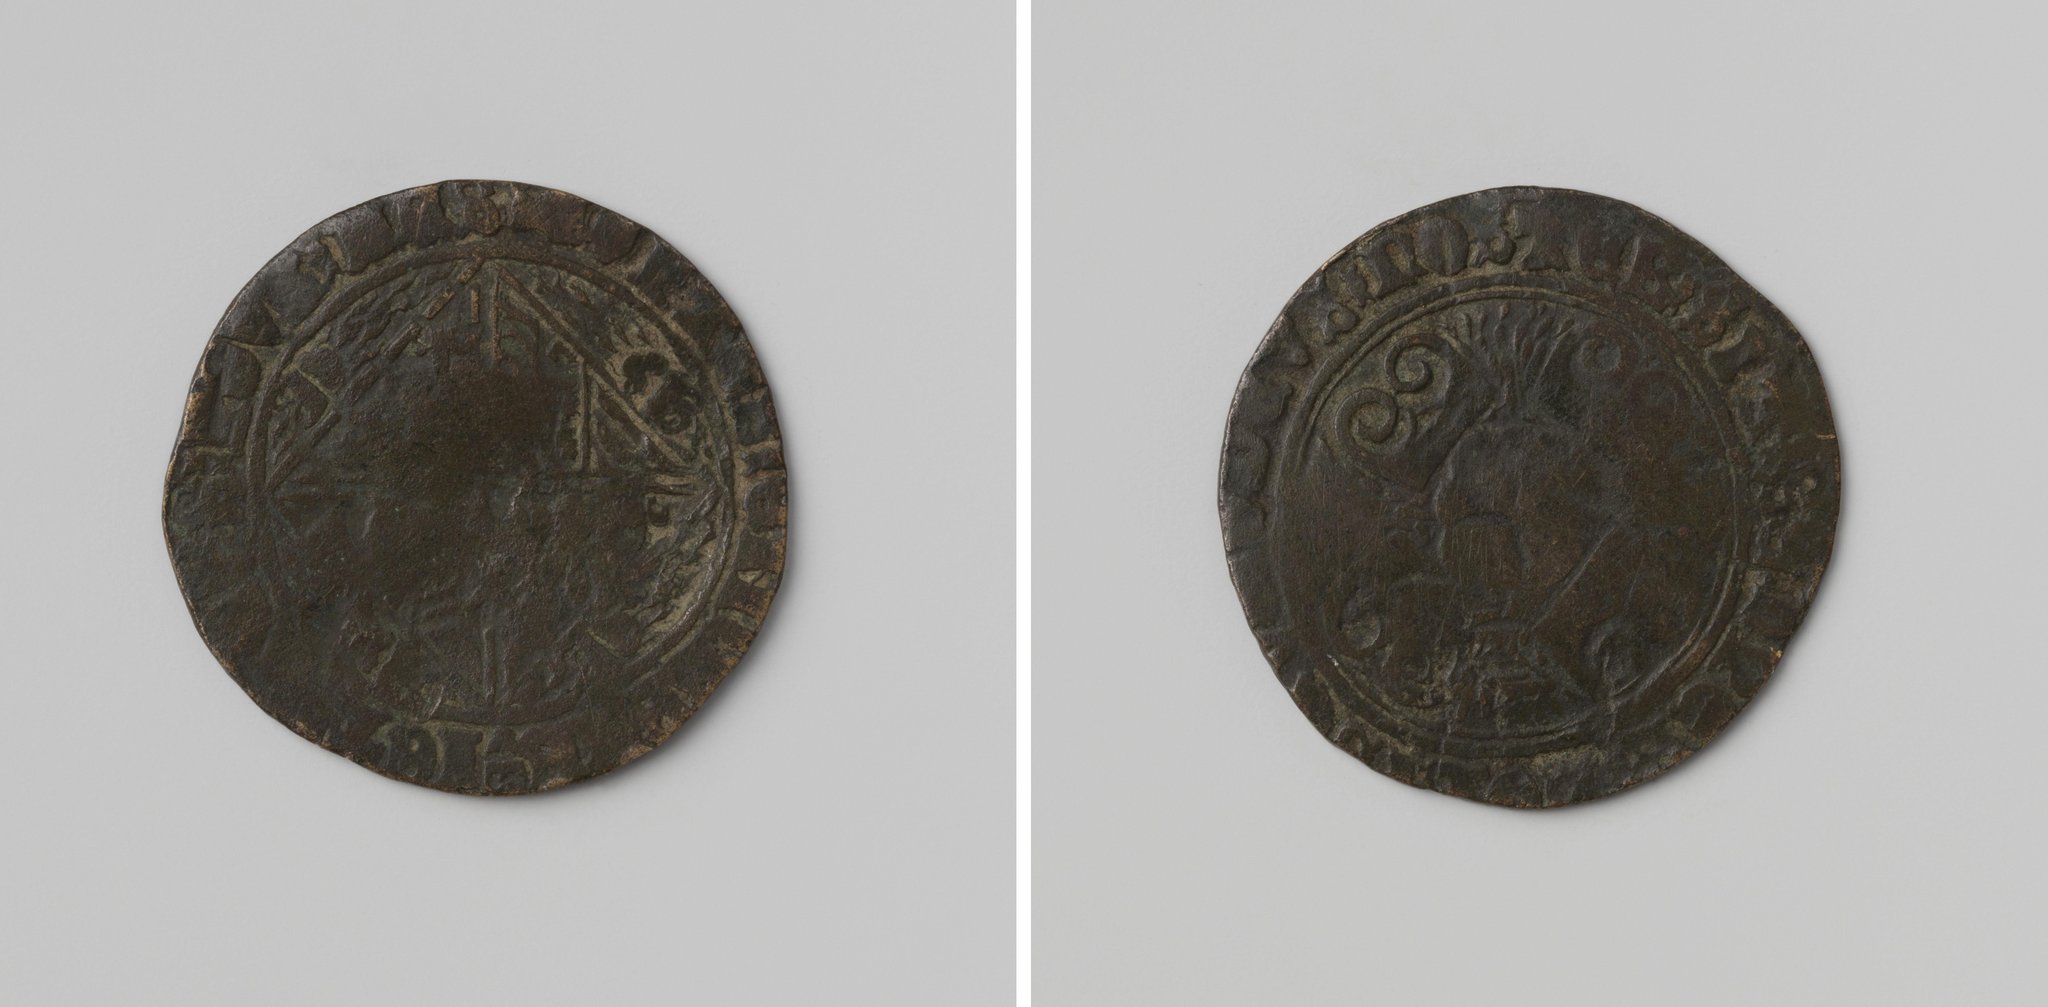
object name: jeton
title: Filips de Goede, hertog van Bourgondie, rekenpenning van het hertogdom Brabant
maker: Anonymous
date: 1430-1467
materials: copper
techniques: striking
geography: leuven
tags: bruges, philip iii the good, brabant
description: Koperen penning. Voorzijde: ruitvormig wapenschild, omgeven door vier vuurslagen binnen omschrift. Keerzijde: kruis van vier vuurslagen, waar vonken uitschieten binnen omschrift